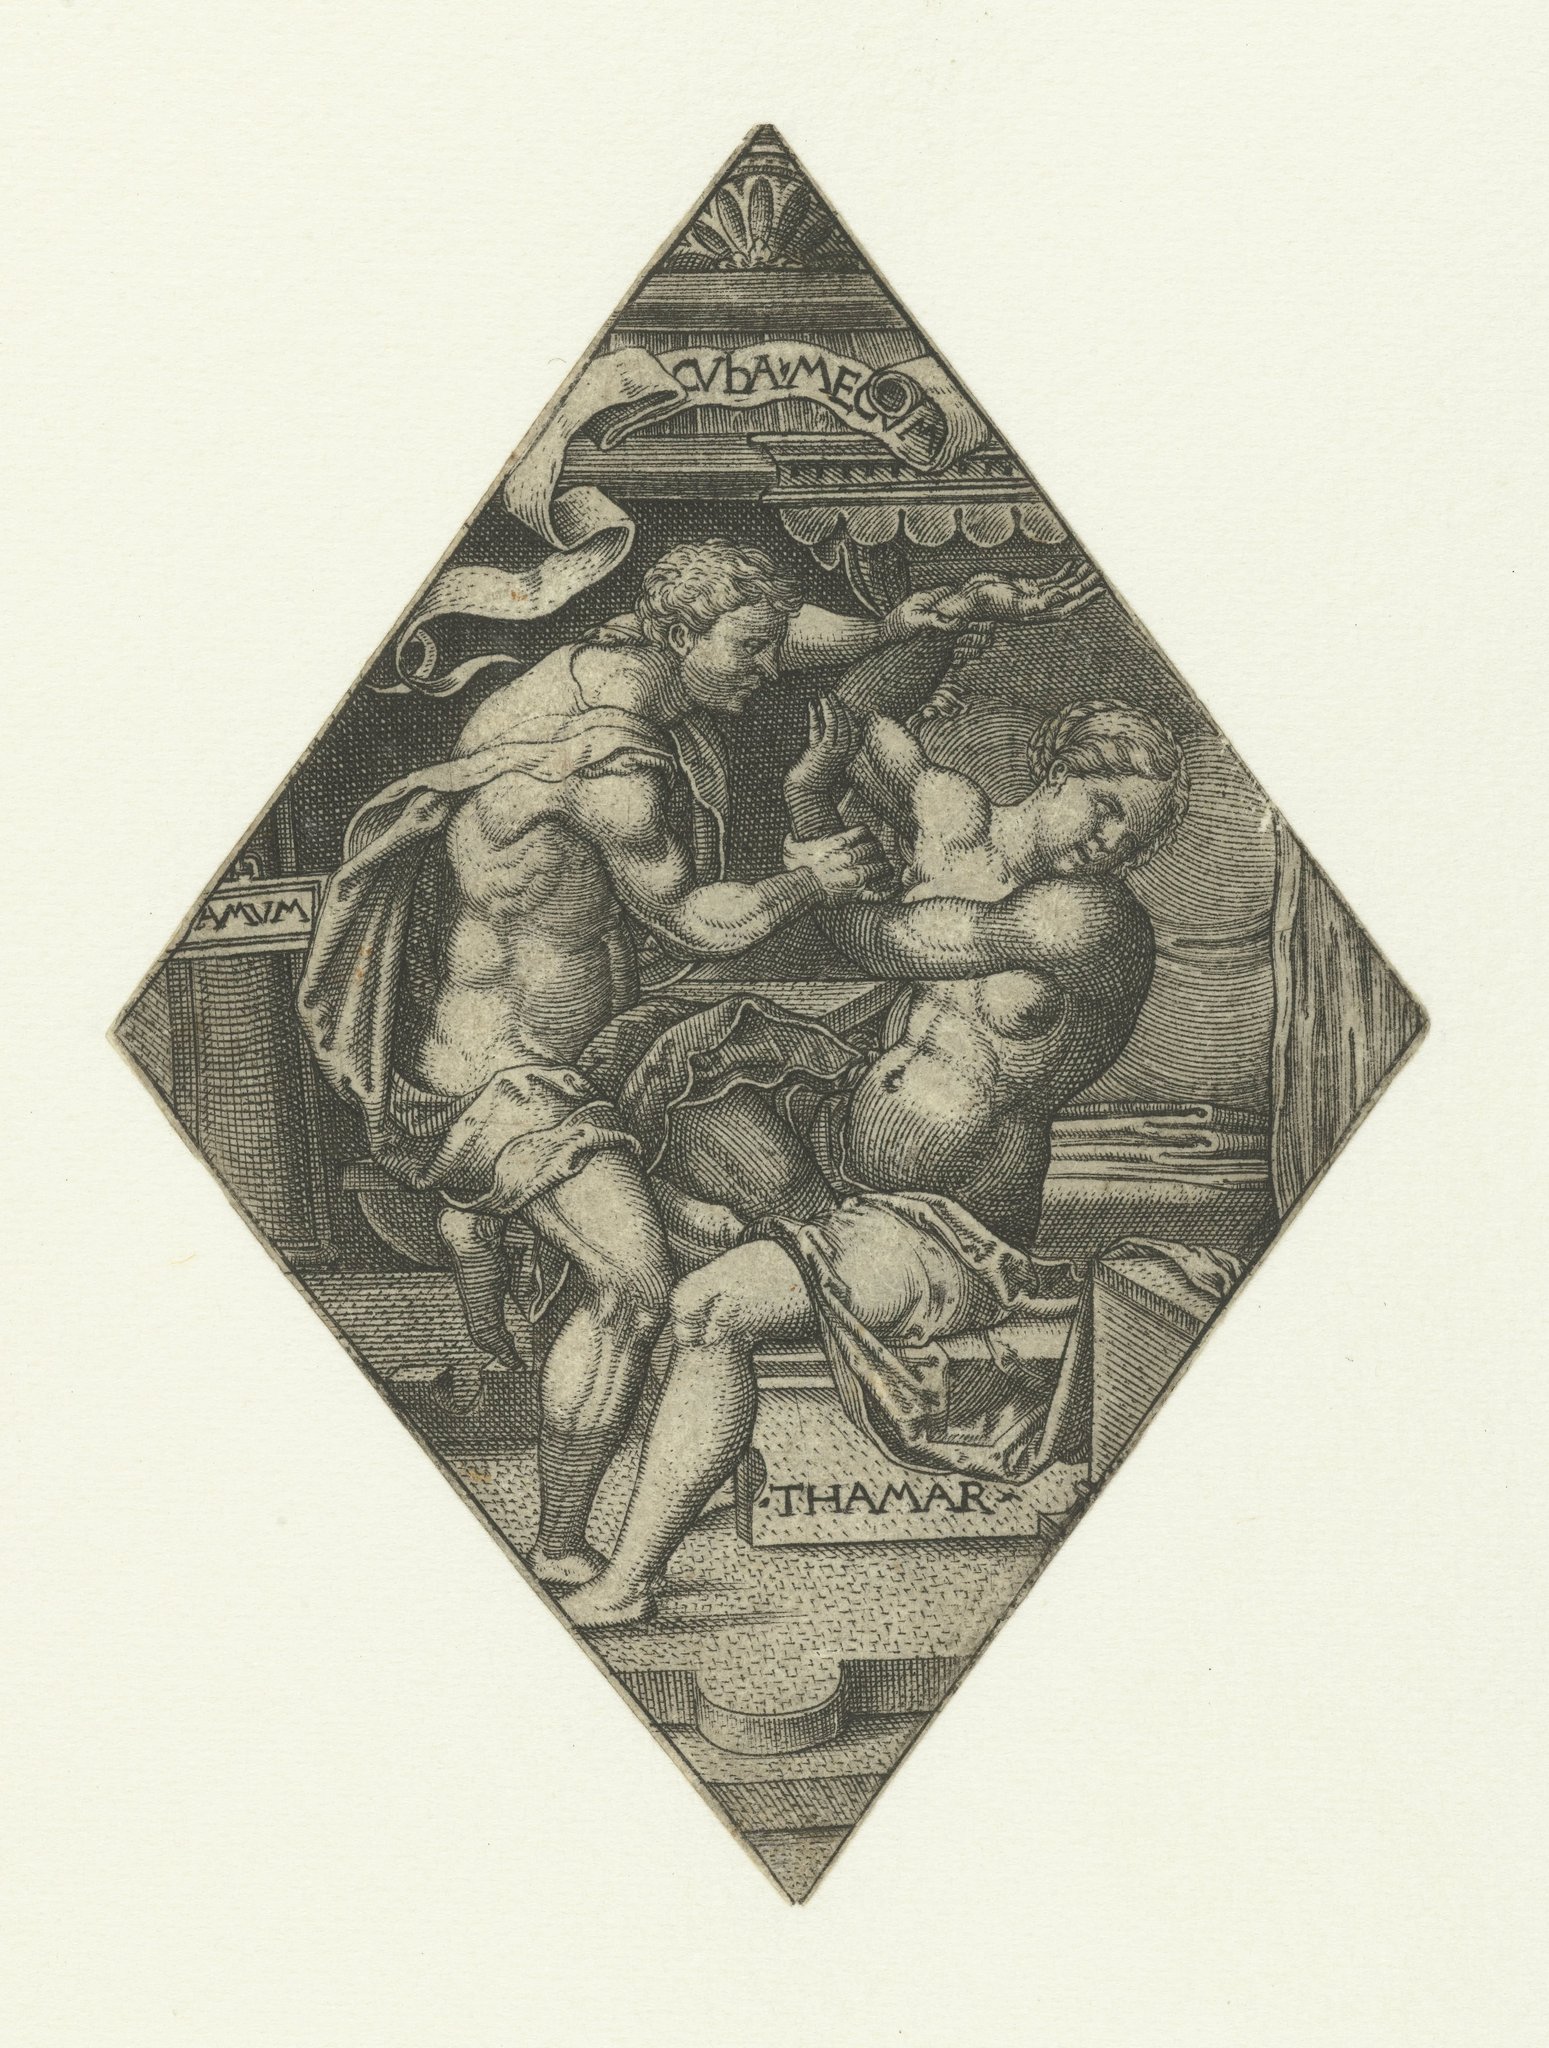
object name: print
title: Tamar onteerd door Amnon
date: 1520-1562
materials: paper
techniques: engraving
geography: low countries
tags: tamar dishonoured; story of tamar and amnon (2 samuel 13)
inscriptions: collector's mark: Lugt 2773, collector's mark: Lugt 2228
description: In slaapvertrek houdt Amnon Tamar vast, beide ontkleed.